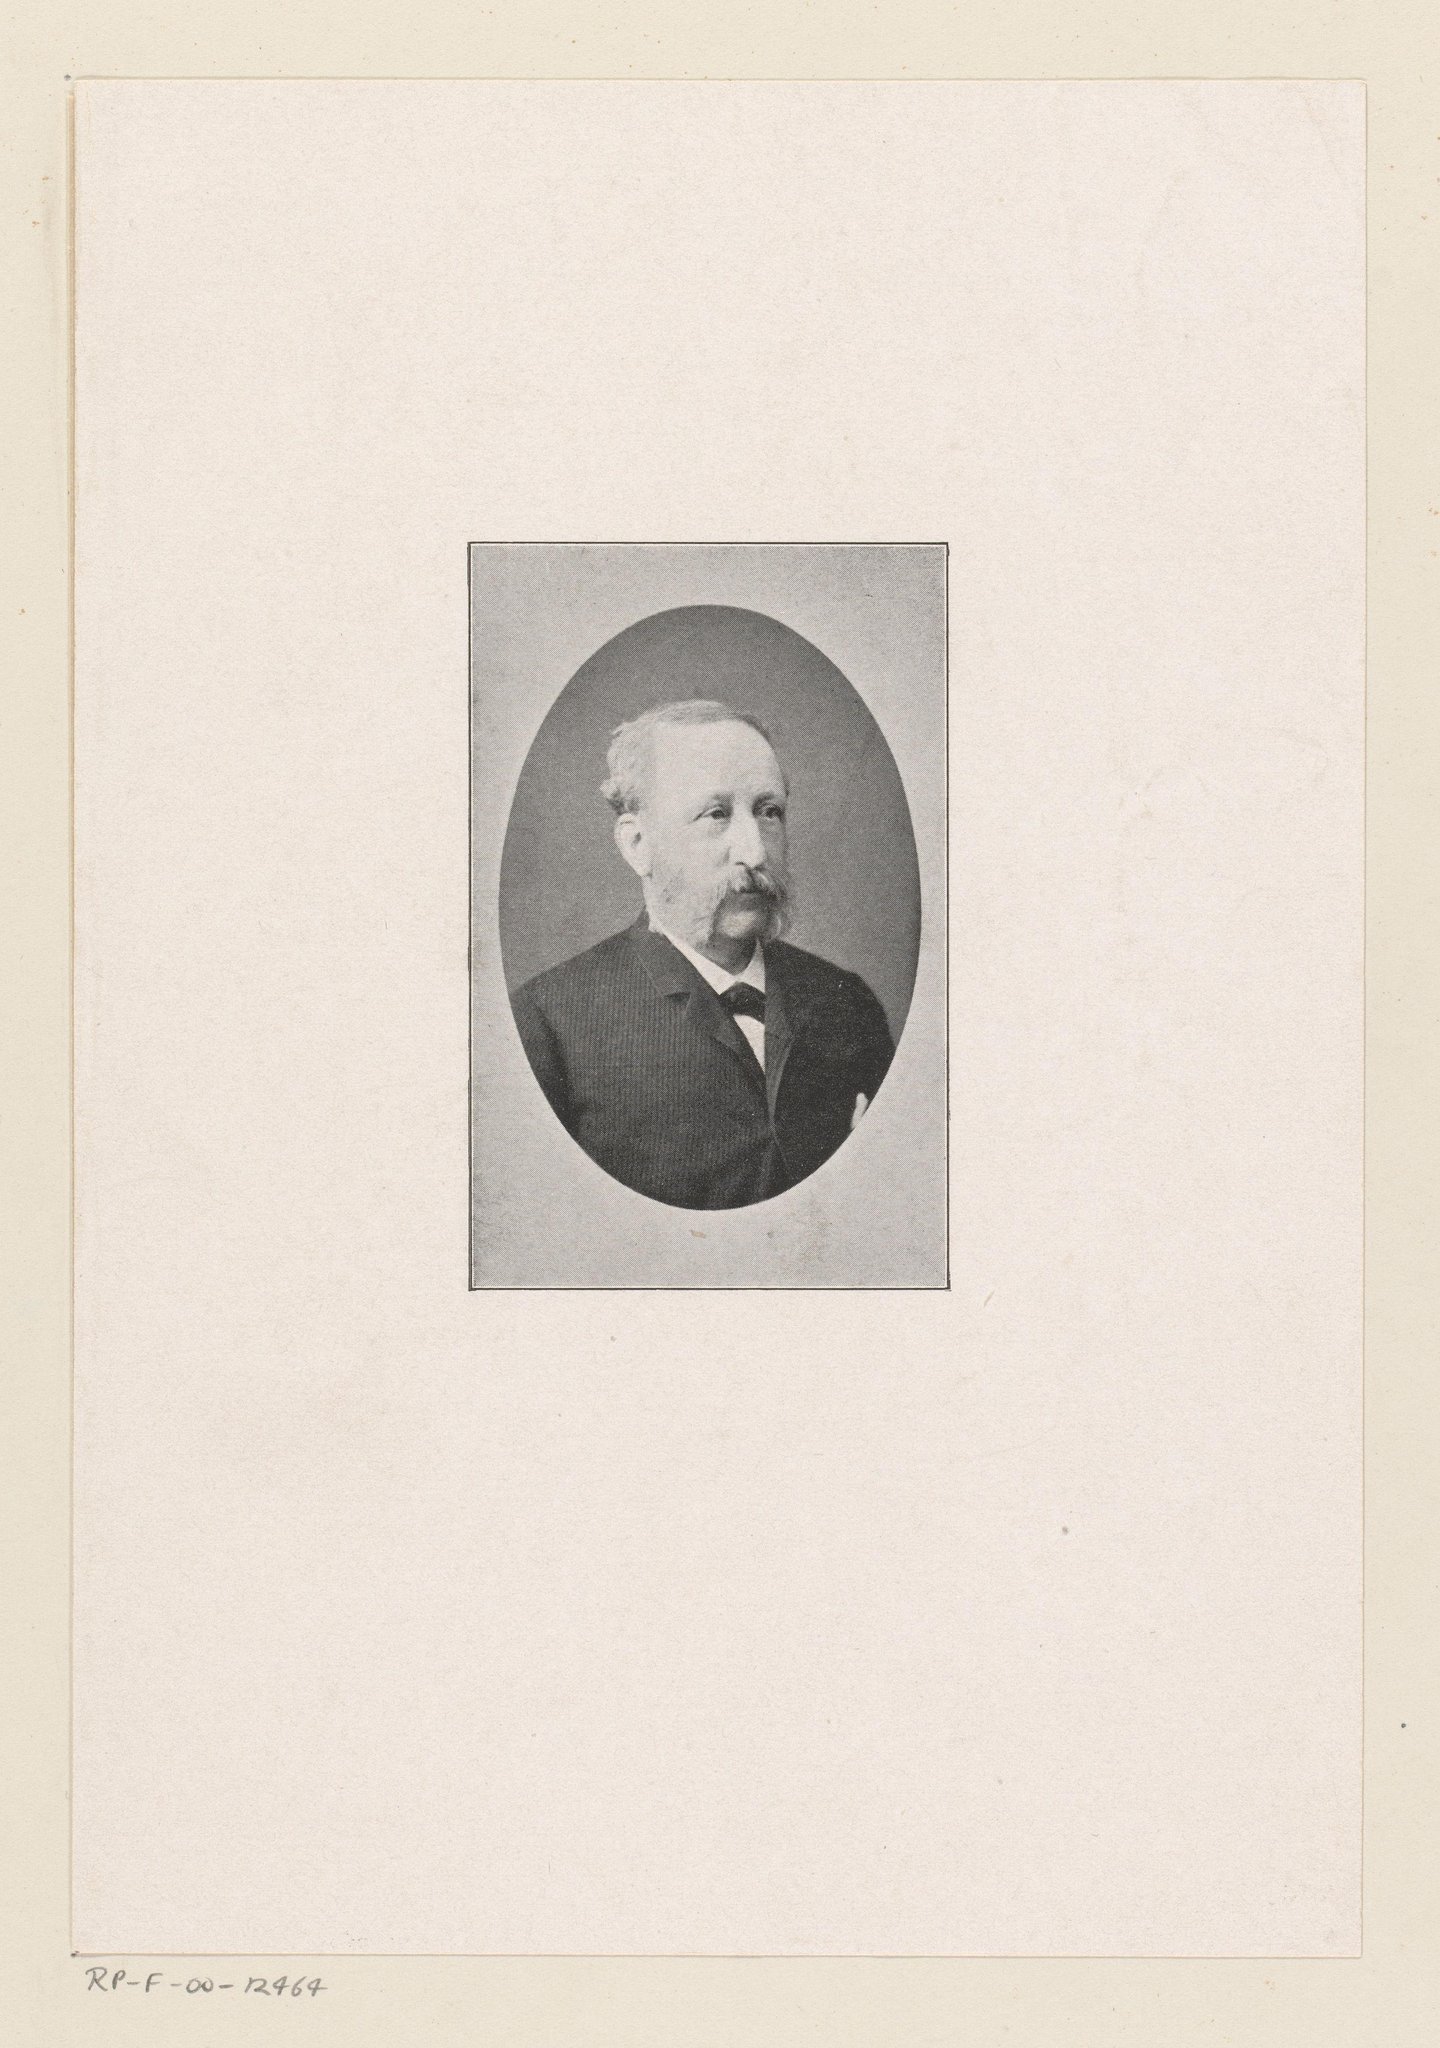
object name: carte de visite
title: Fotoreproductie van een carte-de-visite met het portret van architect Frits van Gendt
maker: Anonymous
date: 1880-1900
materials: paper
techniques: autotype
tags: the hague, frits van gendt, historical persons, portrait, self-portrait of architect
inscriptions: inscription: ‘F.W. v. Gendt J. Jzn’